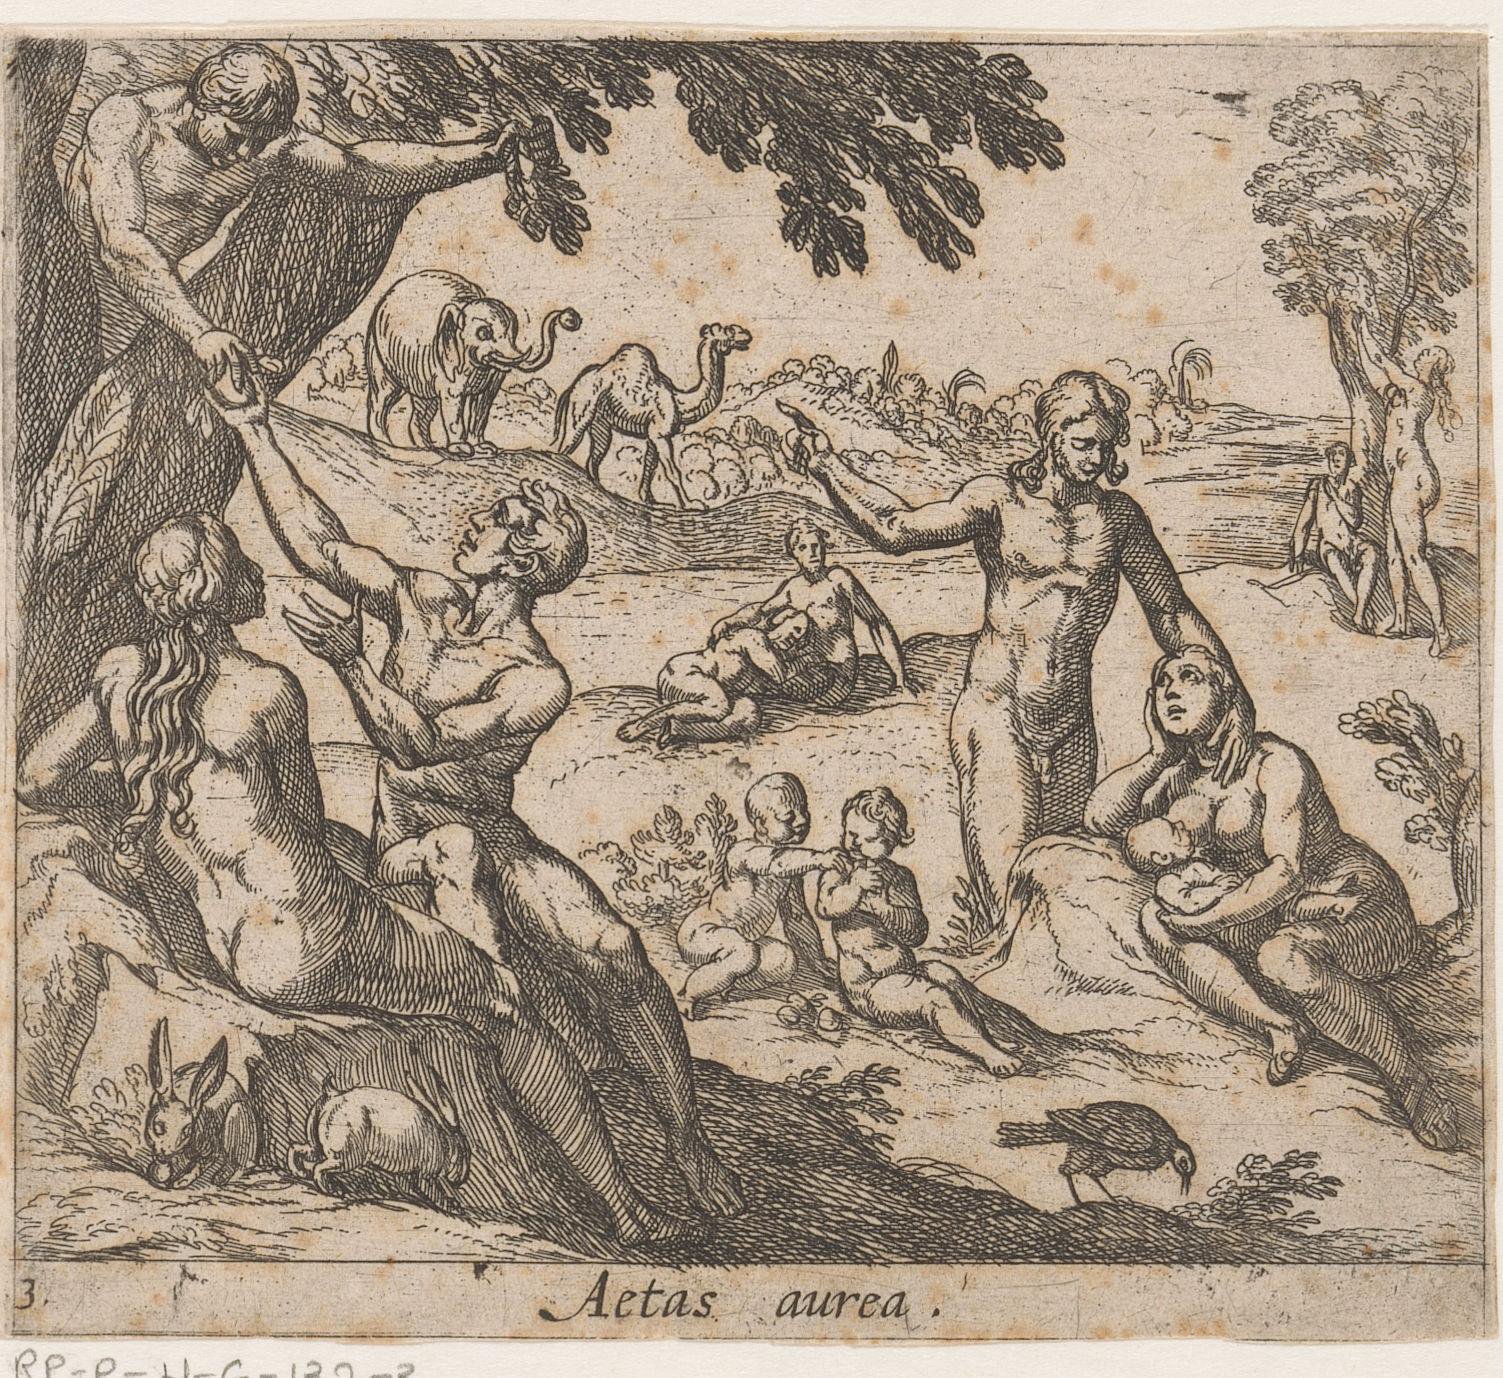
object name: print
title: Aetas aurea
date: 1606-1638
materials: paper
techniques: etching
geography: italy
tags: the golden age, 'aetas aurea'; men live happily, gathering fruits under the reign of saturn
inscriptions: collector's mark: ‘Hinloopen’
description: Deze prent maakt deel uit van een reeks van 150 prenten (+ titelprent) met voorstellingen van de Metamorfosen van Ovidius.